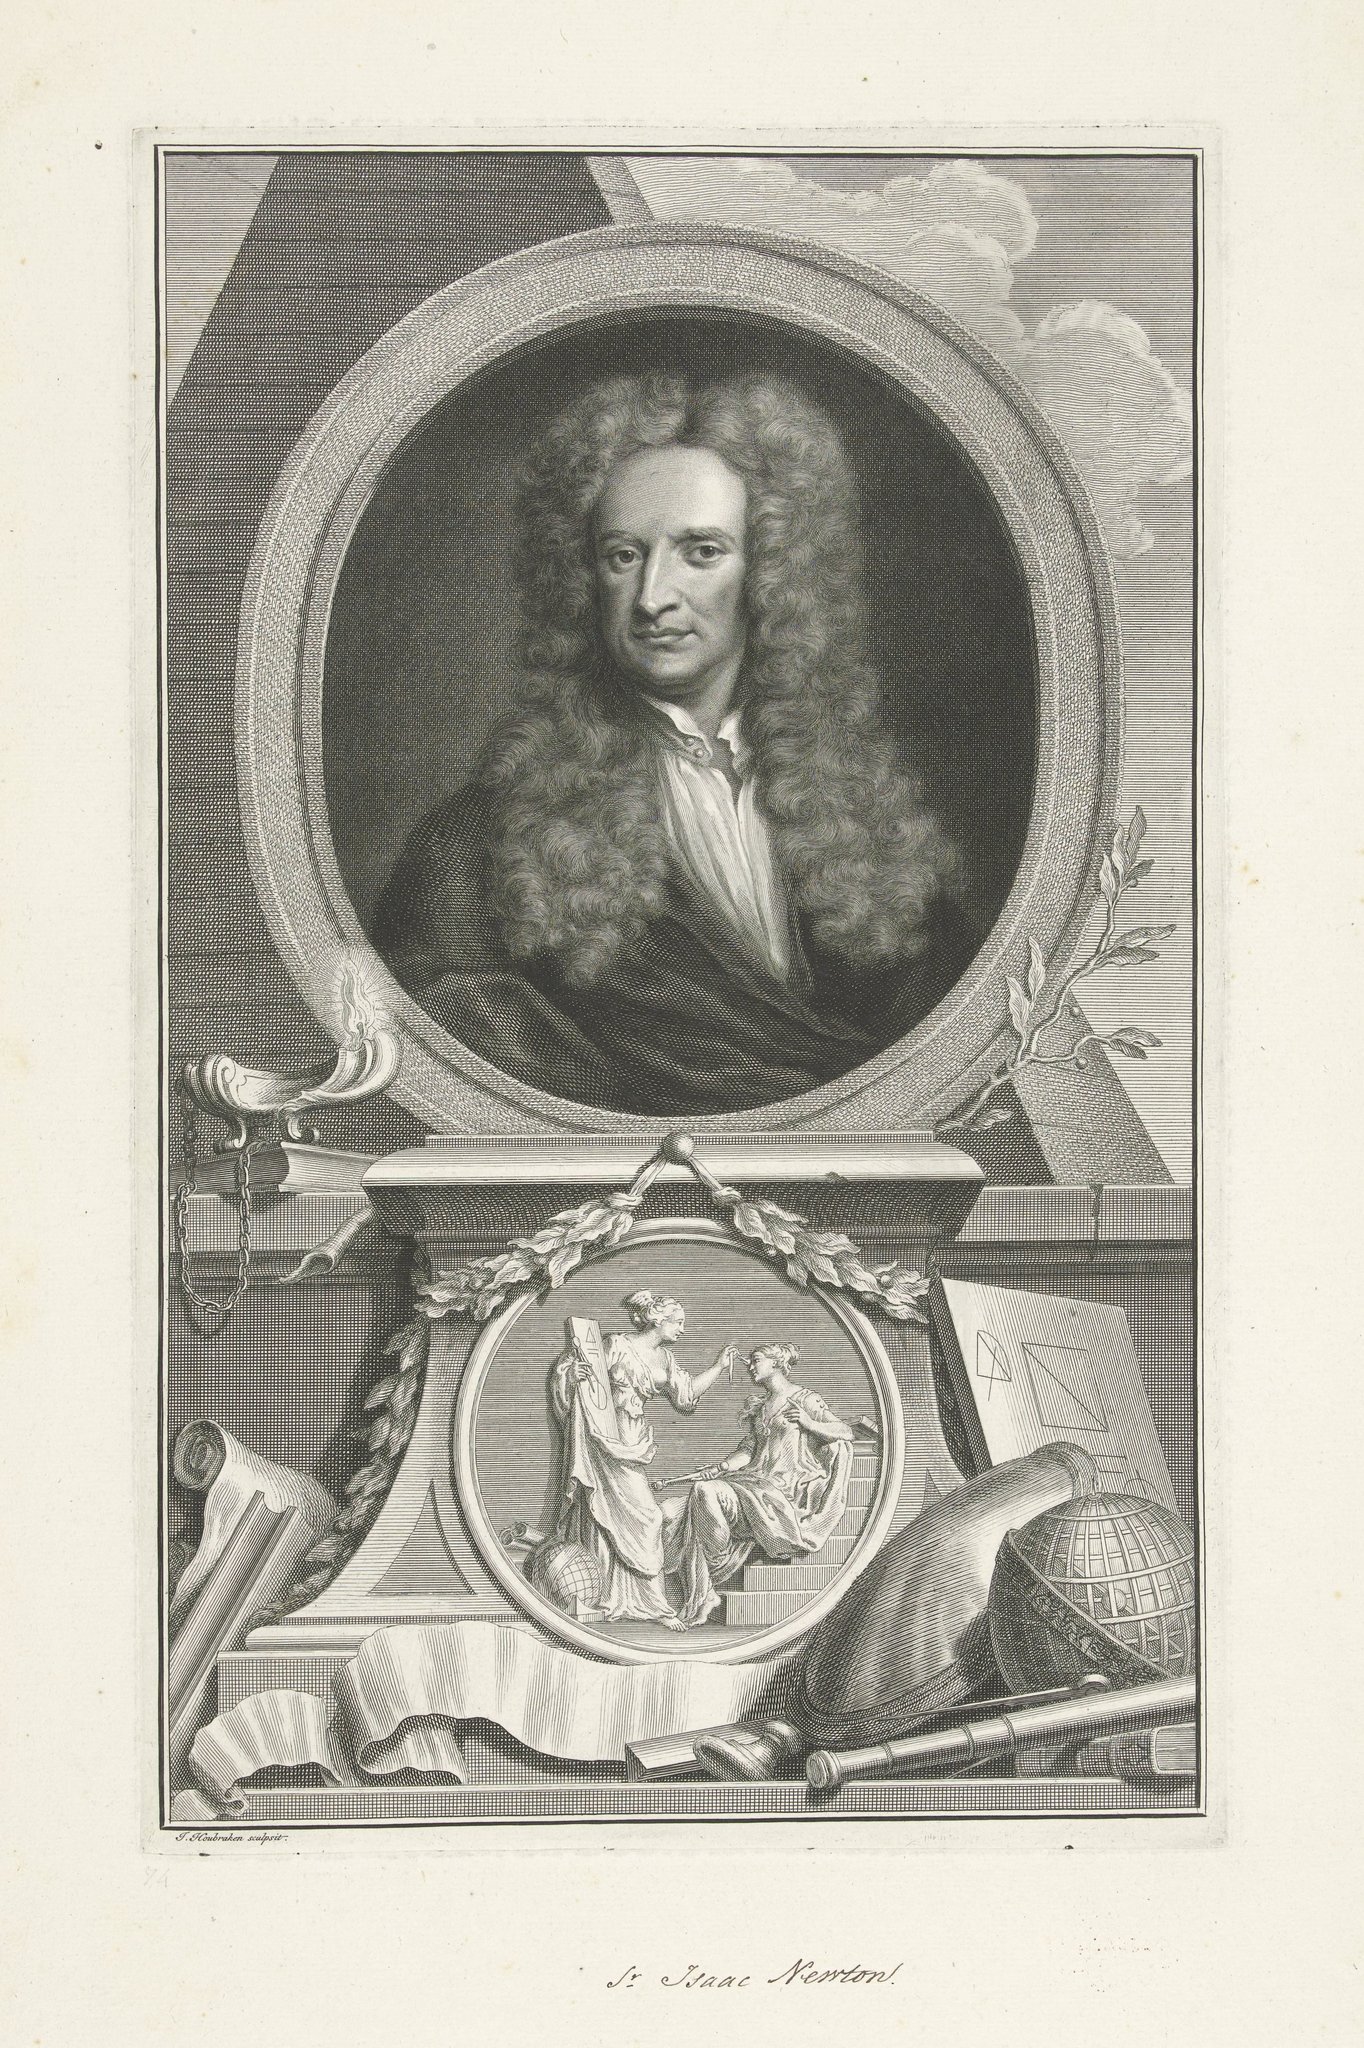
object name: print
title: Portret van Isaac Newton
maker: jacob houbraken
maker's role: draughtsman, print maker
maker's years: 1698-1780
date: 1741-1743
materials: paper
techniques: engraving, etching, pen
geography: amsterdam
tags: london, physicist, historical persons, armillary sphere, skeleton celestial globe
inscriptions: collector's mark: Lugt 240, name: ‘Sr. Isaac Newton’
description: Portret van Isaac Newton met op de achtergrond een piramide. Onder het portret en medaillon met twee allegorische vrouwenfiguren met meetinstrumenten en een plaquette met geometrische figuren. Rechts een sterrenkijker en een armillarium met de tekenen van de dierenriem.